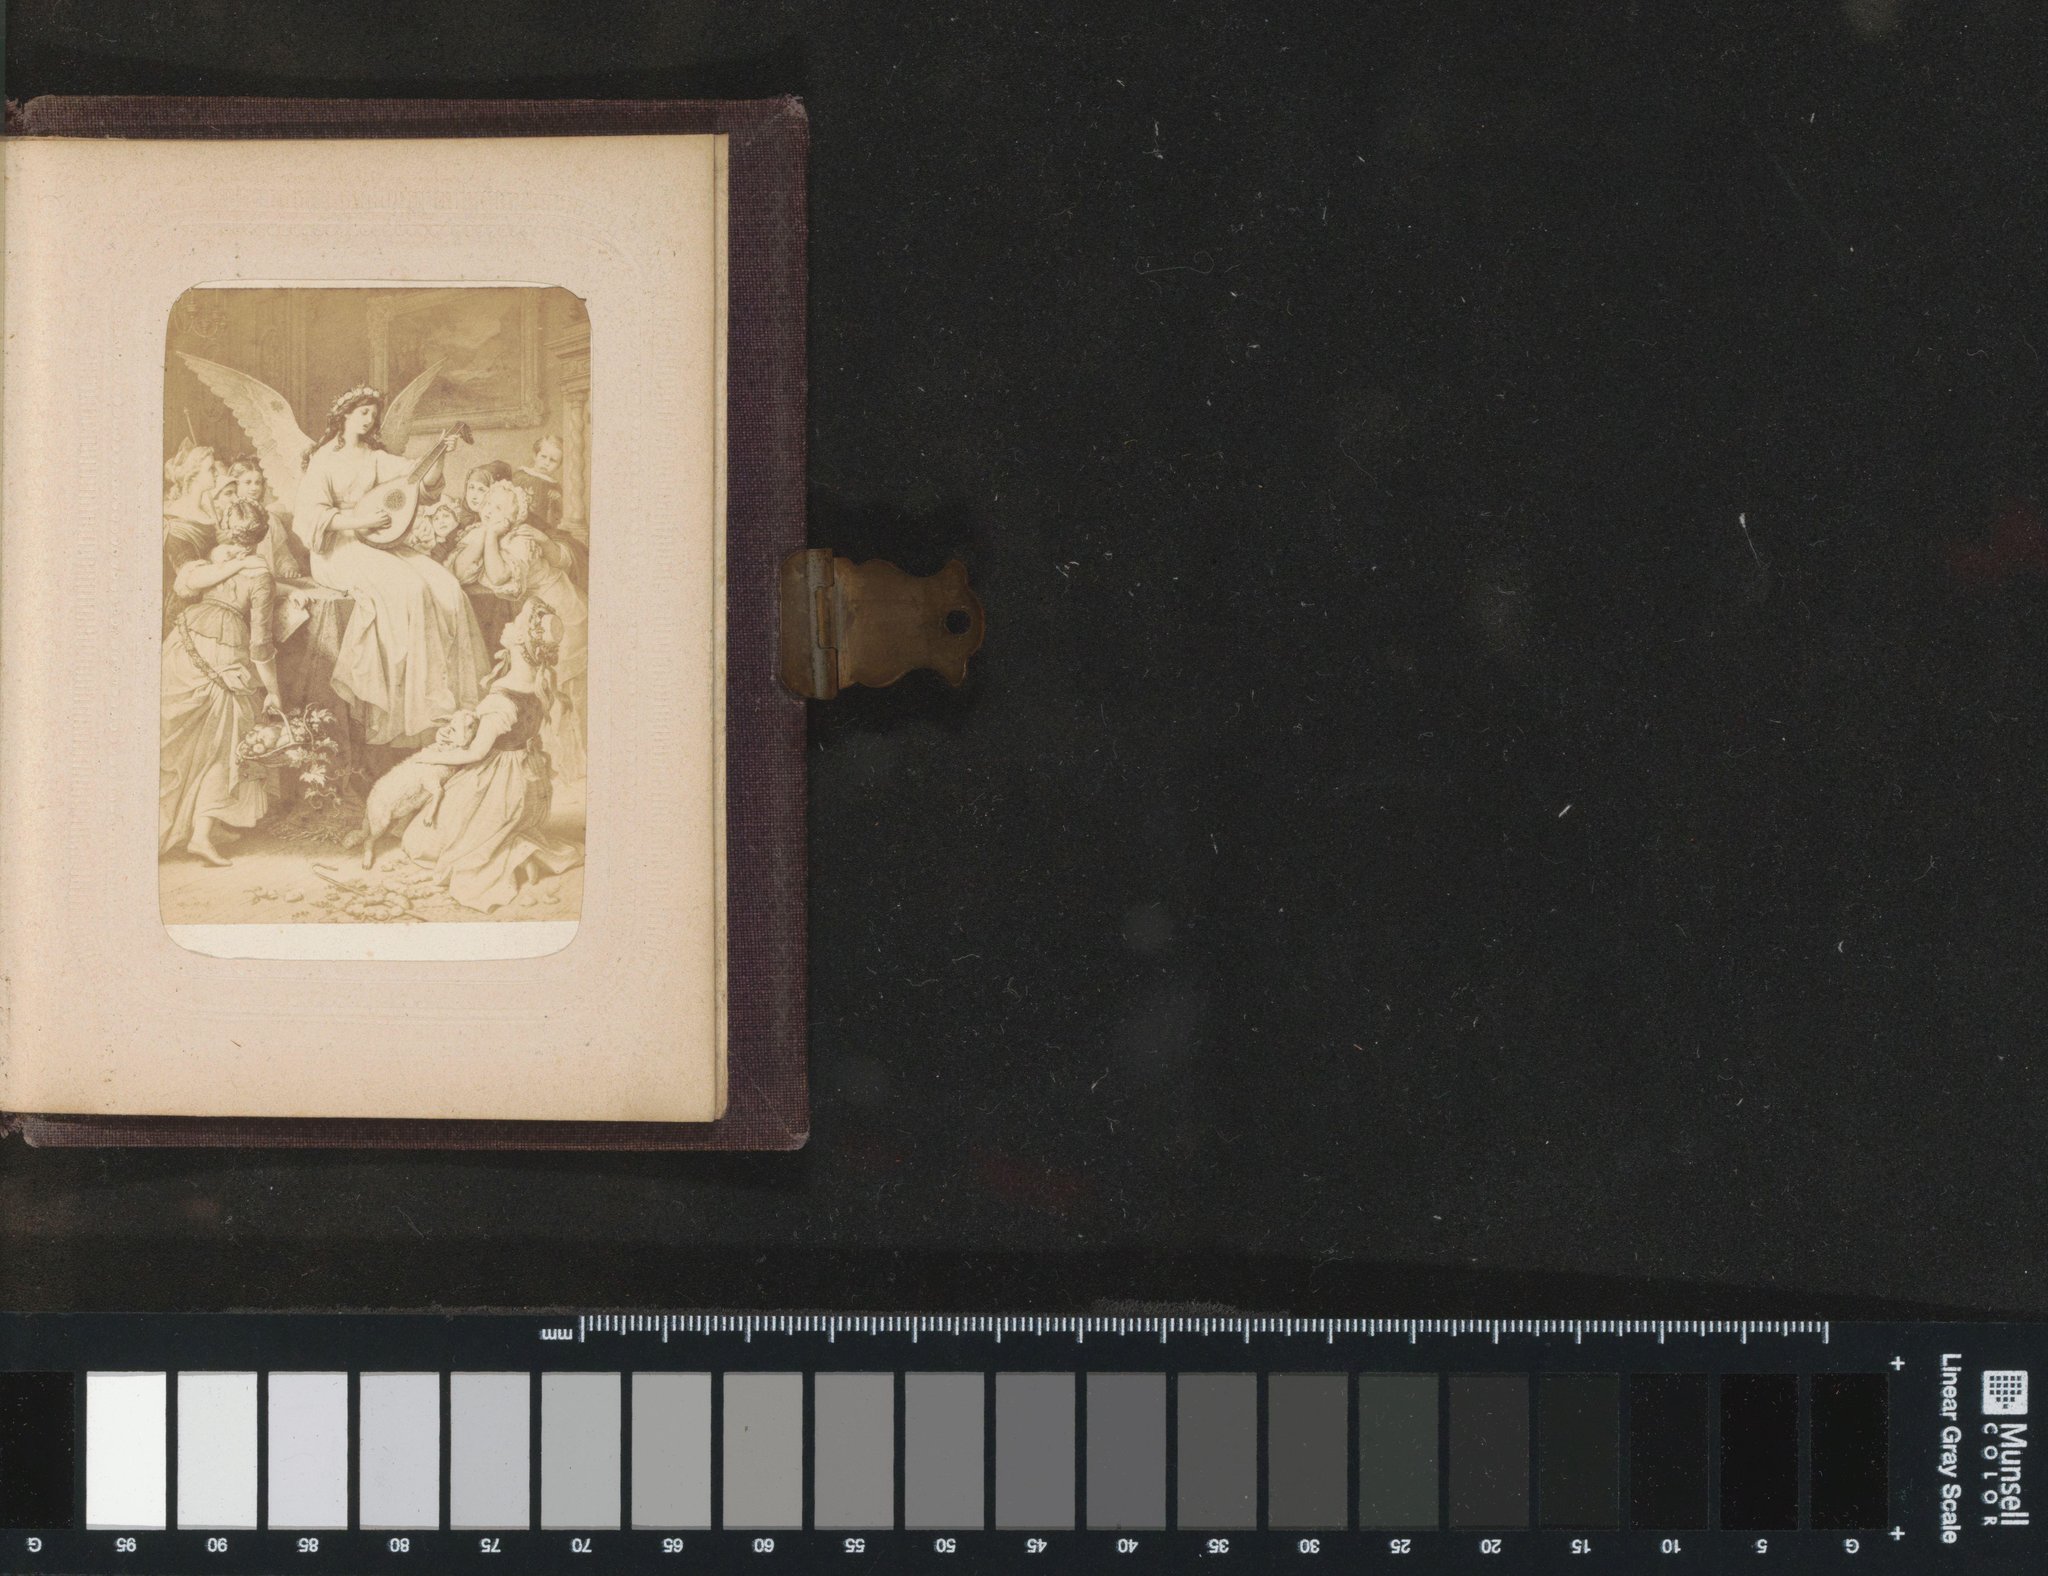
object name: reproduction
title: Mignon (Wilhelm Meister) W. von Kaulbach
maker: andries jager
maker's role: publisher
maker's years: 1825-1905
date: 1860-1890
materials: cardboard, paper, photographic support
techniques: albumen print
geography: amsterdam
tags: adolescent, young woman, maiden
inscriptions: address: ‘Water 110 Amsterdam’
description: Onderdeel van Fotoalbum met 16 cartes-de-visite van vrouwenfiguren uit het werk van J.W. von Goethe.